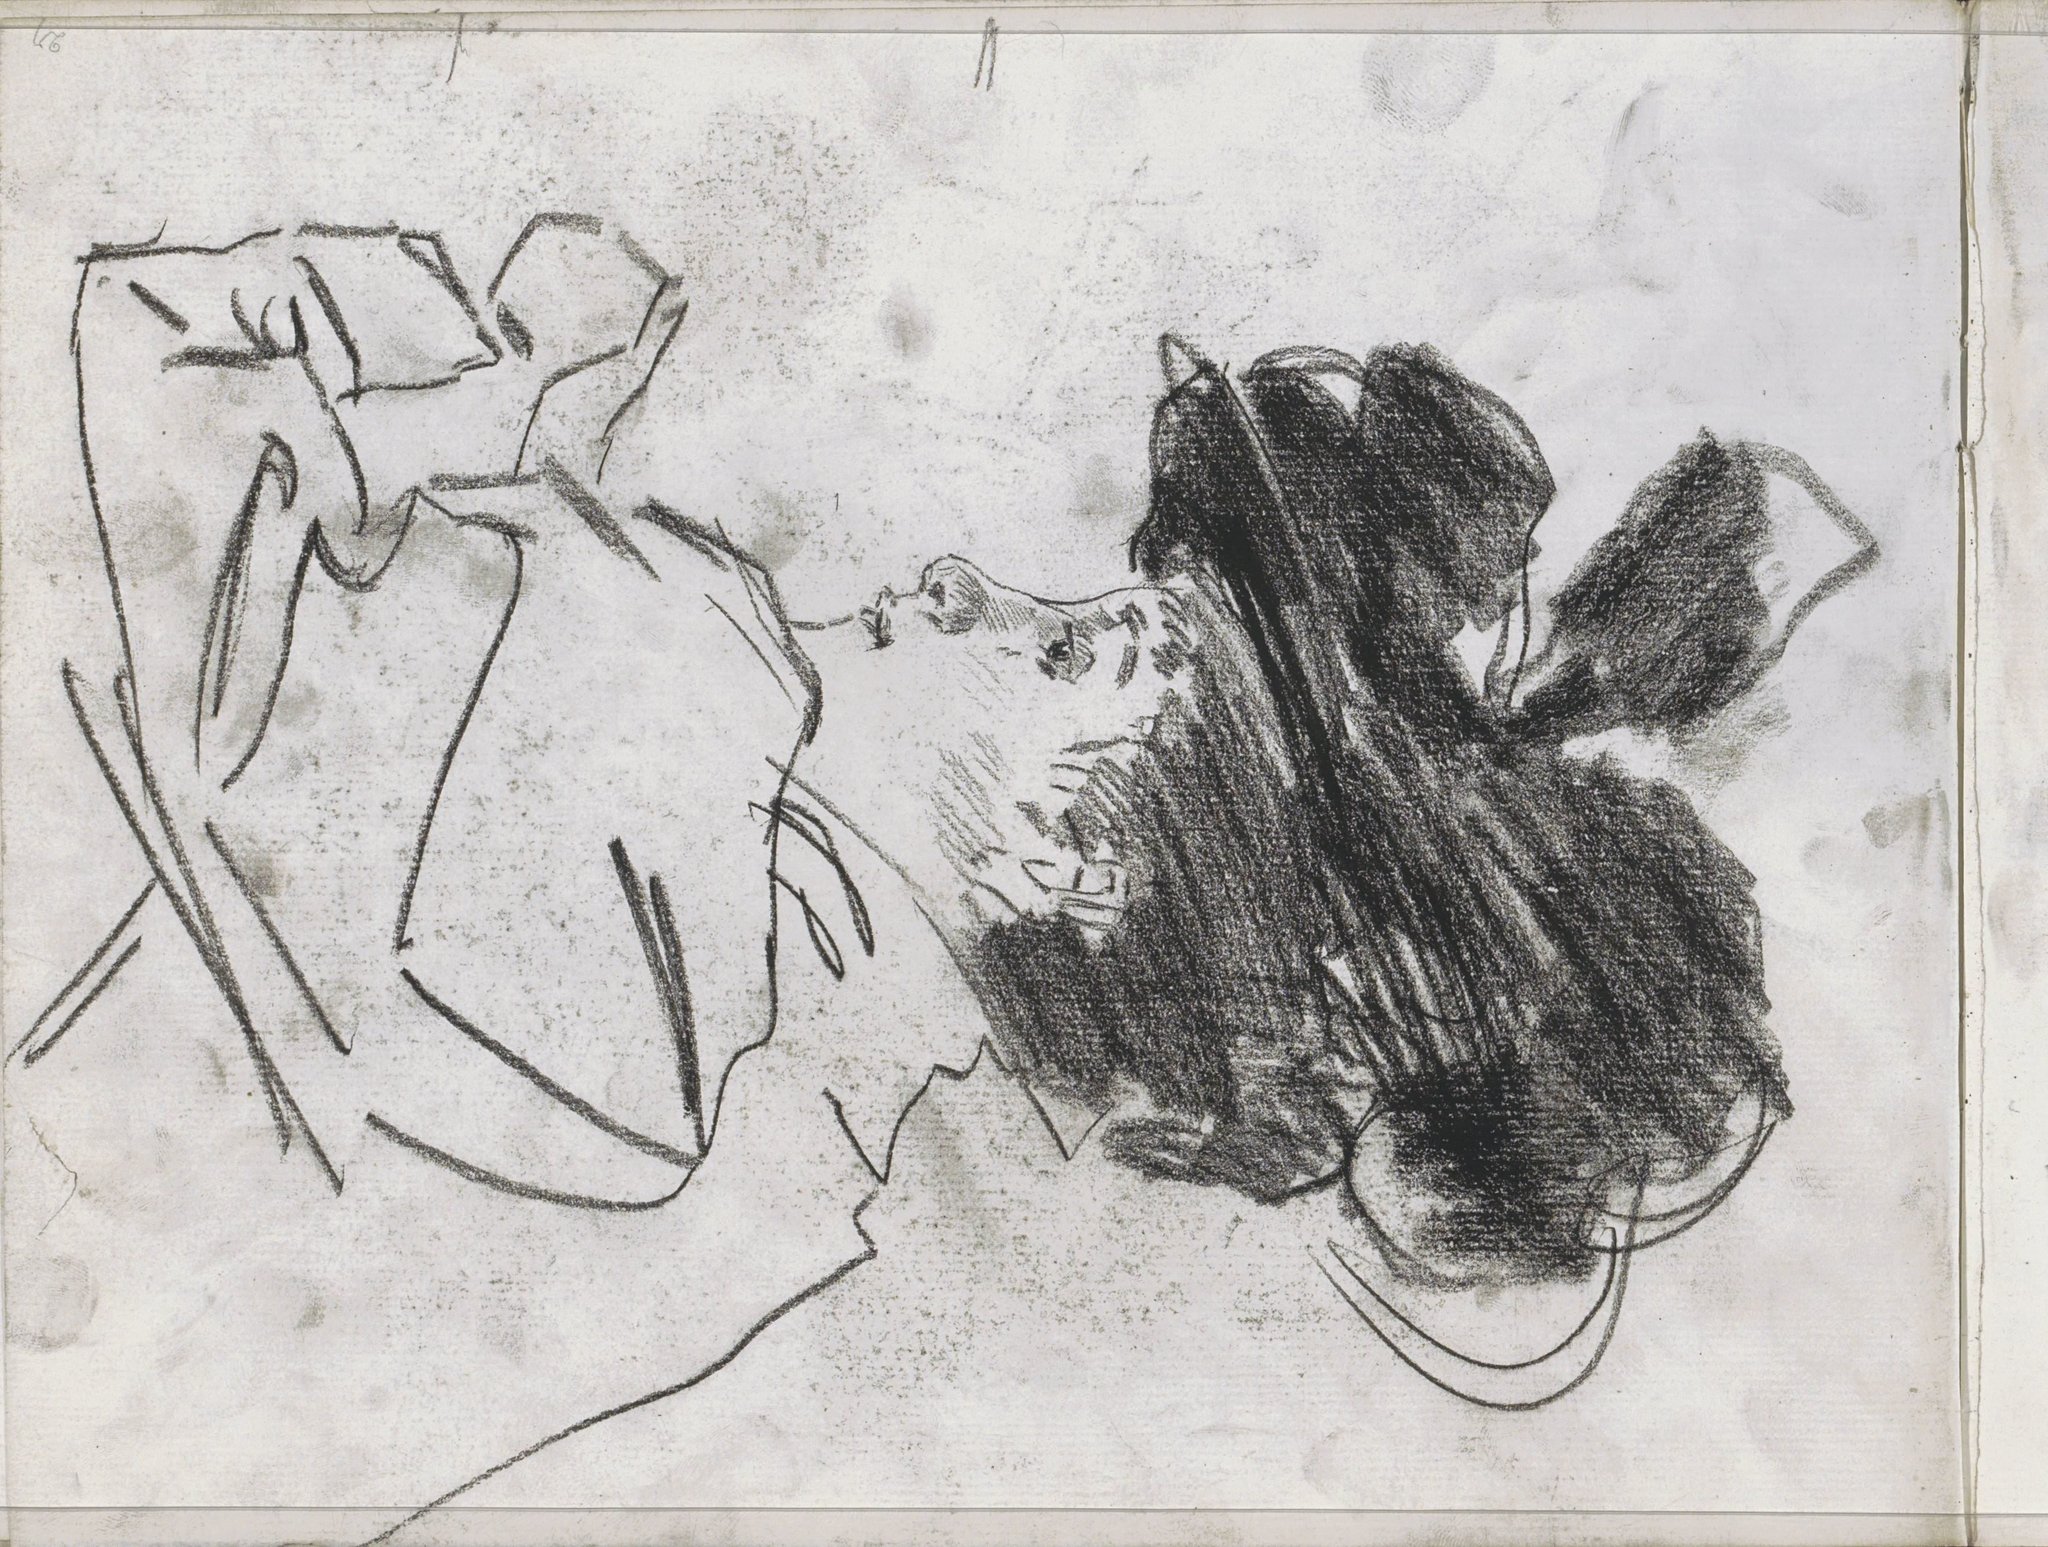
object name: sketchbook leaf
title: Vrouw met hoed, in profiel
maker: isaac israels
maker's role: draughtsman, painter, print maker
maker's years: 1865-1934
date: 1875-1934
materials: chalk, paper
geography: the hague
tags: head-gear: hat (+ women's clothes), adult woman (+ sideview, profile)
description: Blad 8 verso uit schetsboek XIV met 17 bladen.